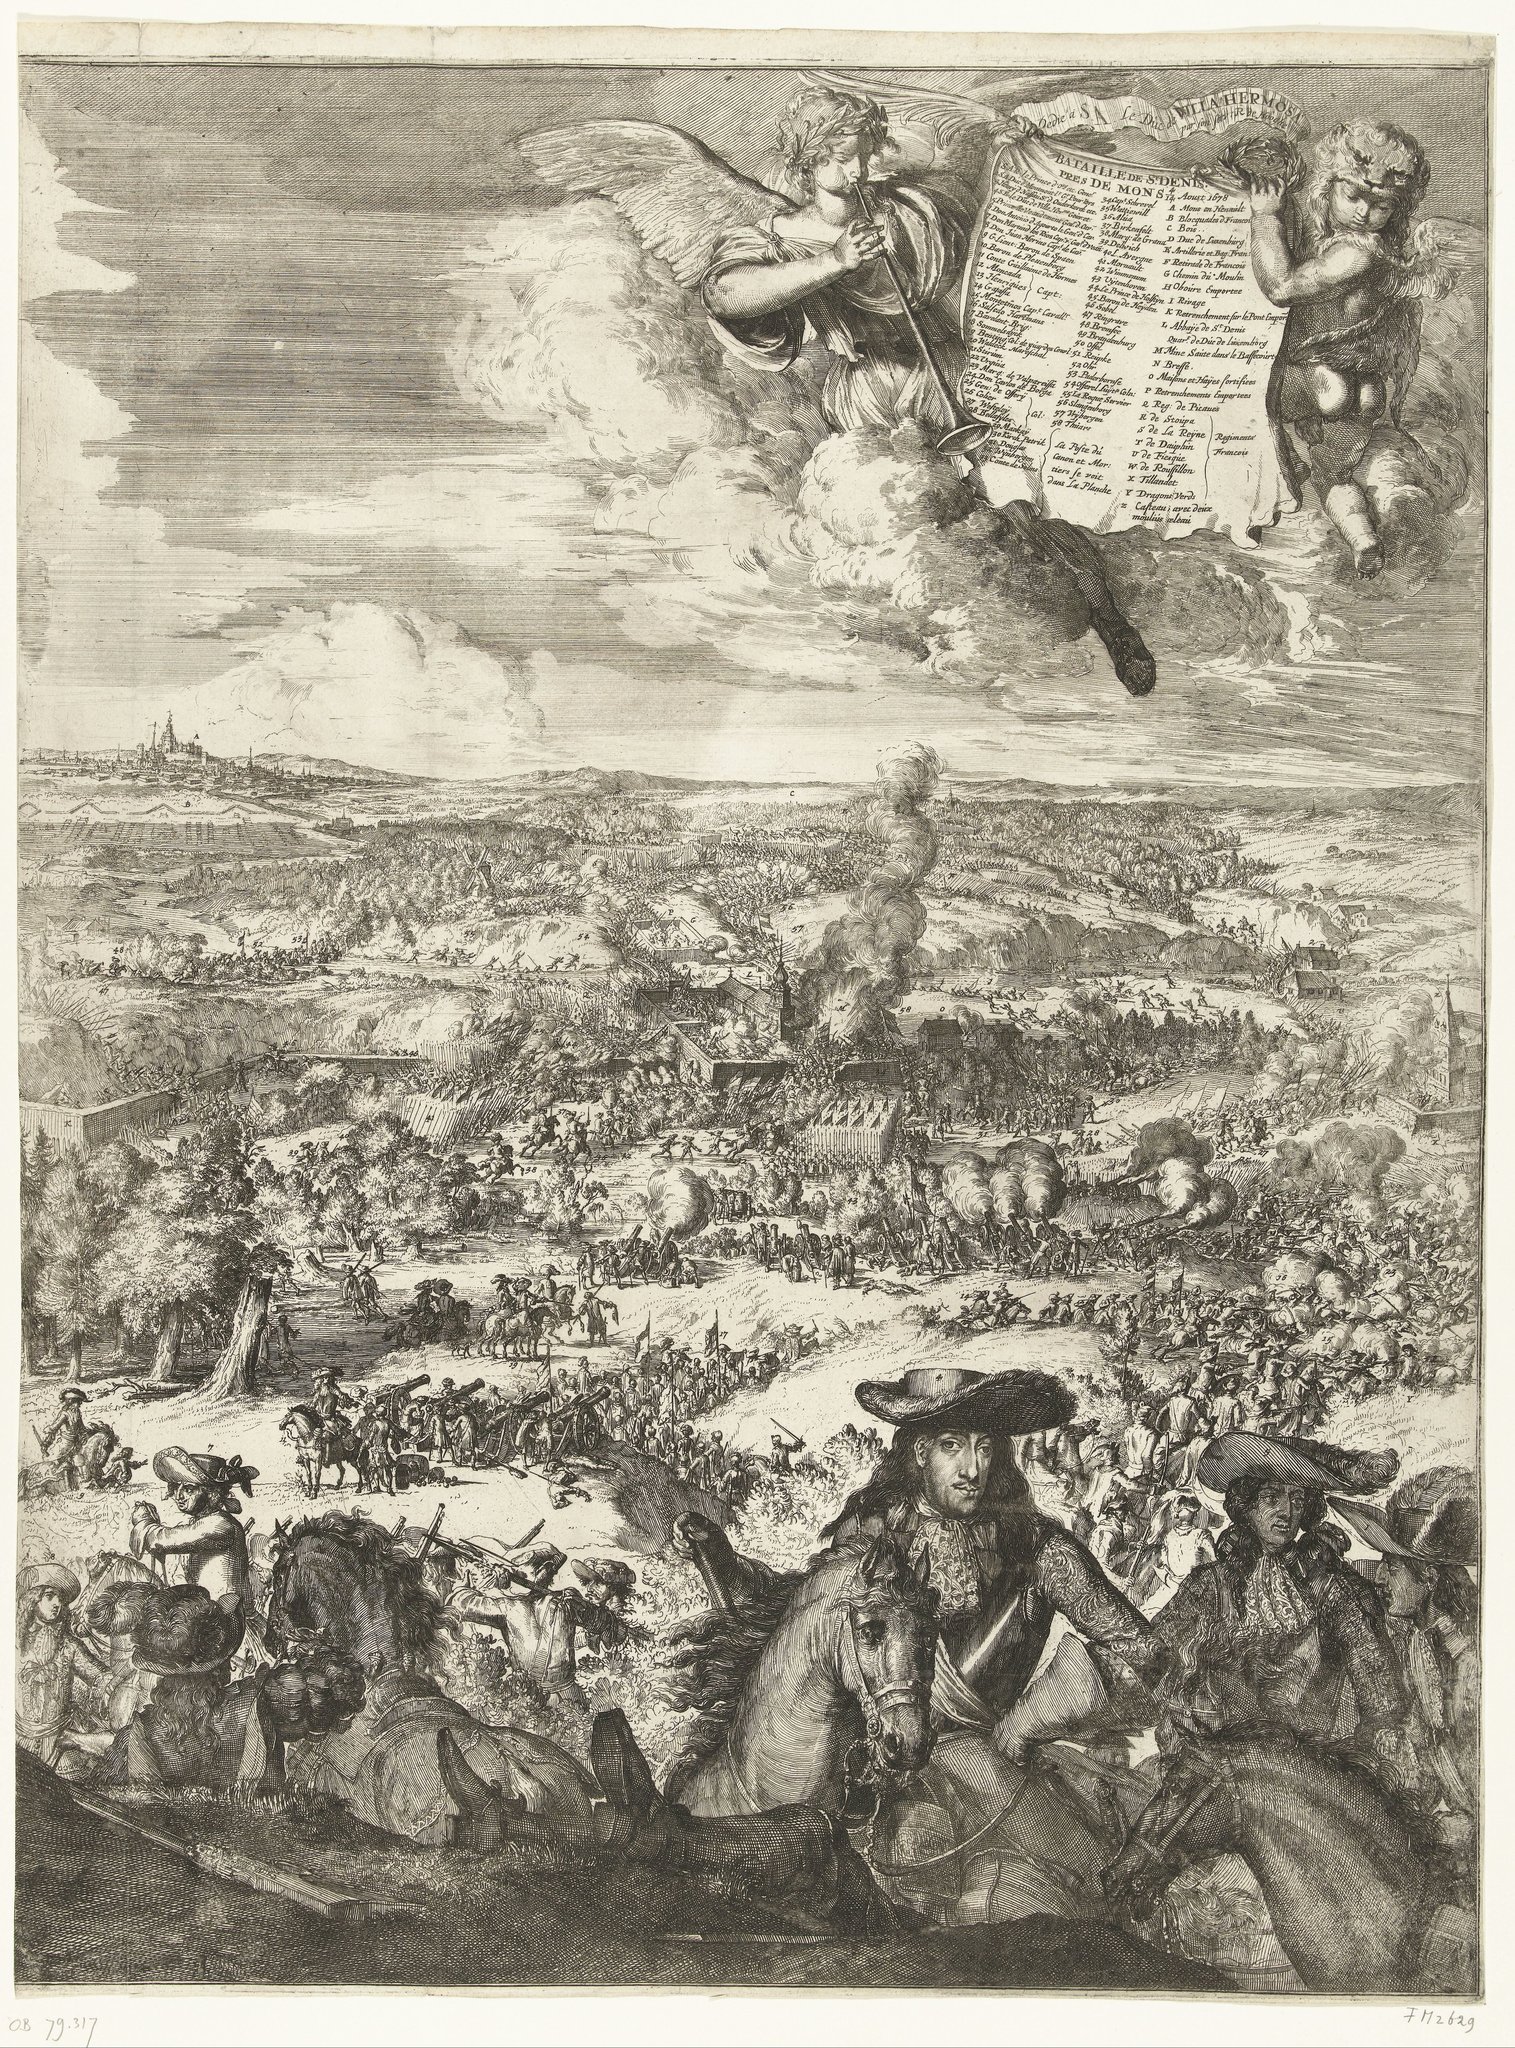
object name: print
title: Bataille de St. Denis. Pres de Mons 4/14 Aoust 1678.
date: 1678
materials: paper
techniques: etching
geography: amsterdam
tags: the hague, william iii (prince of orange and king of england, scotland, and ireland), politician, carlos de aragón de gurrea (9th duke of villahermosa), battle, fighting in general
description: Grote voorstelling van slag bij St. Denis op 14 augustus 1678, op twee bladen, rechter blad. Gezicht op het slagveld, rechtsonder de hertog van Villahermosa. In de lucht vliegt Faam blazend op haar bazuin, in de hand een cartouche met de legenda's 1-58 en A-Z in het Frans.